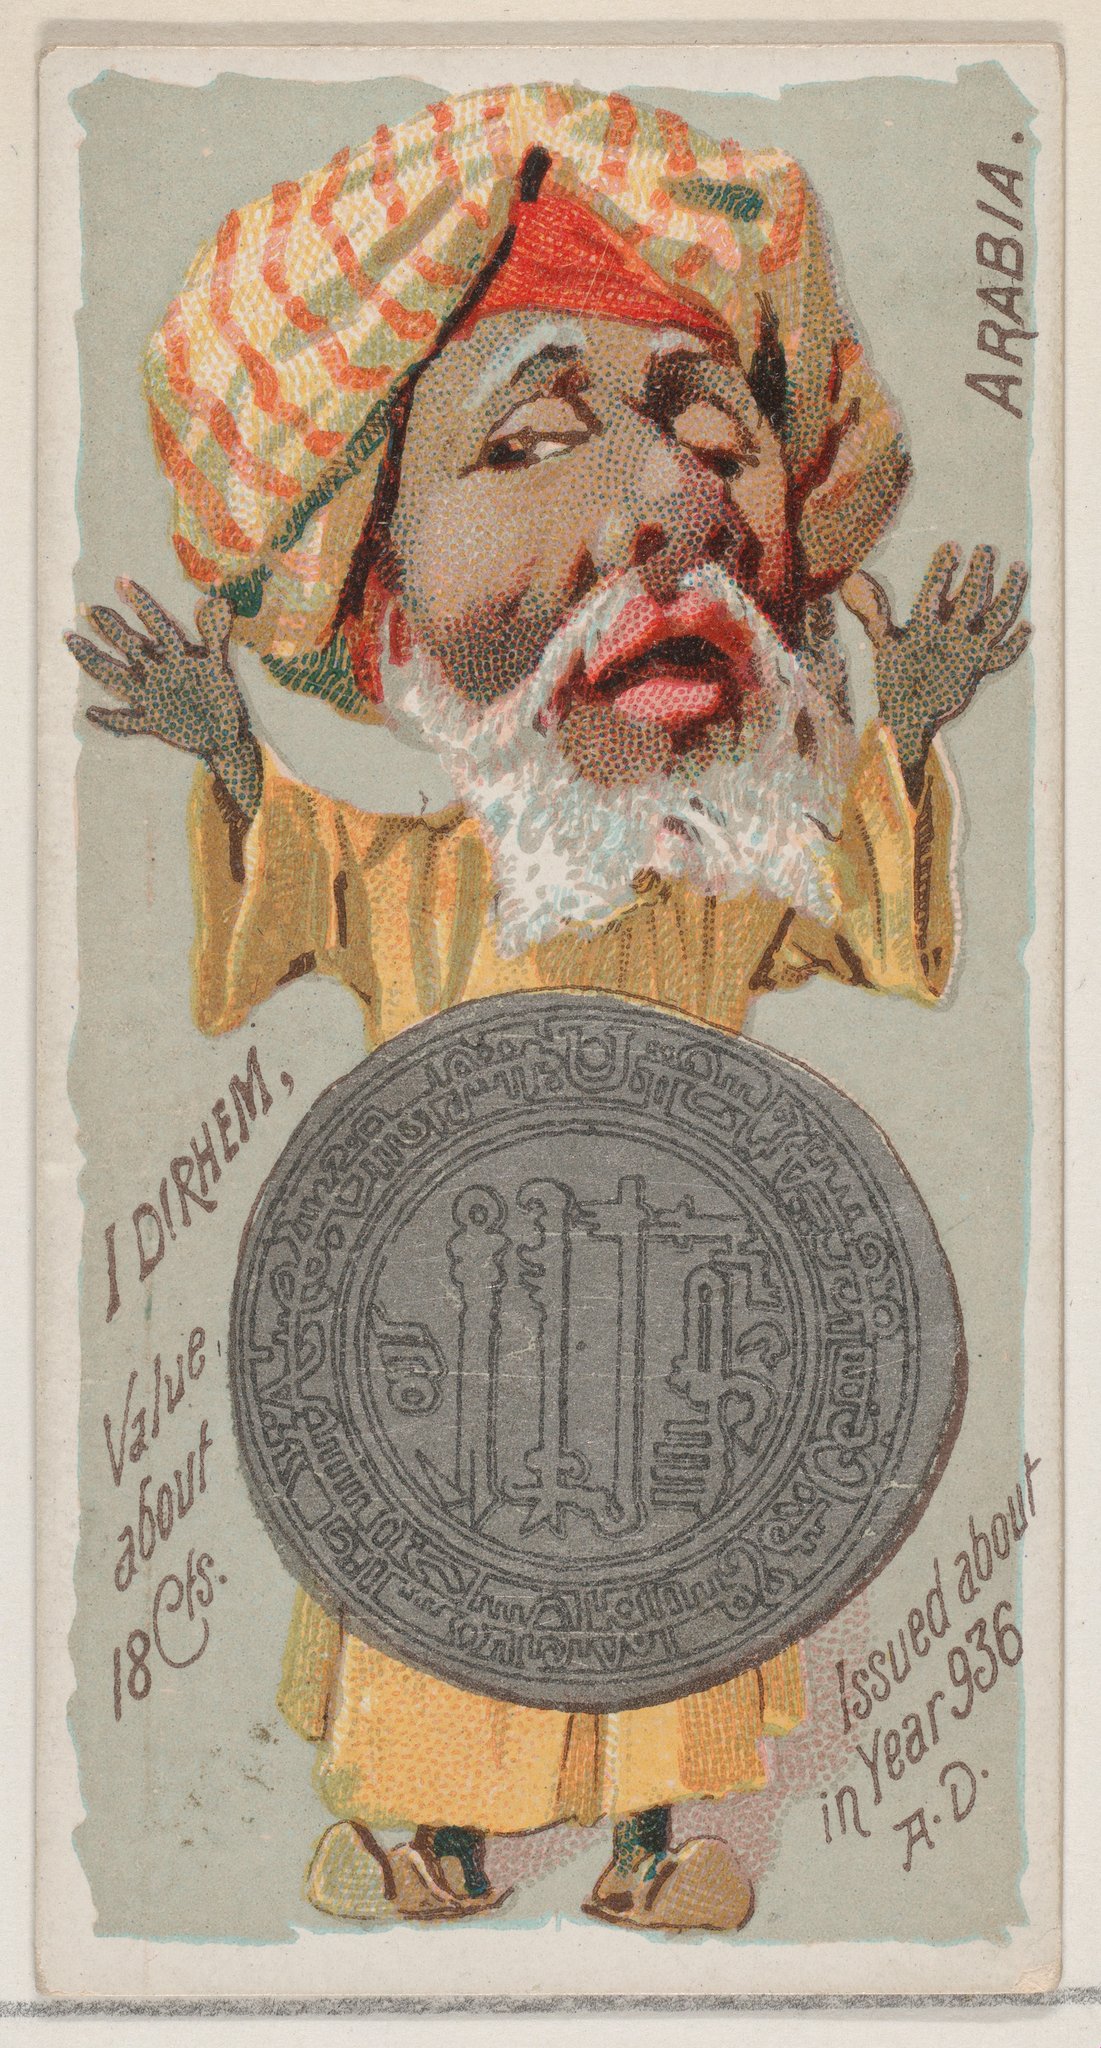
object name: print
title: Caricatured Arabian, 1 Dirhem, from the series Coins of All Nations (N72, variation 2) for Duke brand cigarettes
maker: w. duke, sons & co.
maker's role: publisher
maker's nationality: american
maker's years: 1870-1920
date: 1889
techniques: color lithograph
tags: men,coins